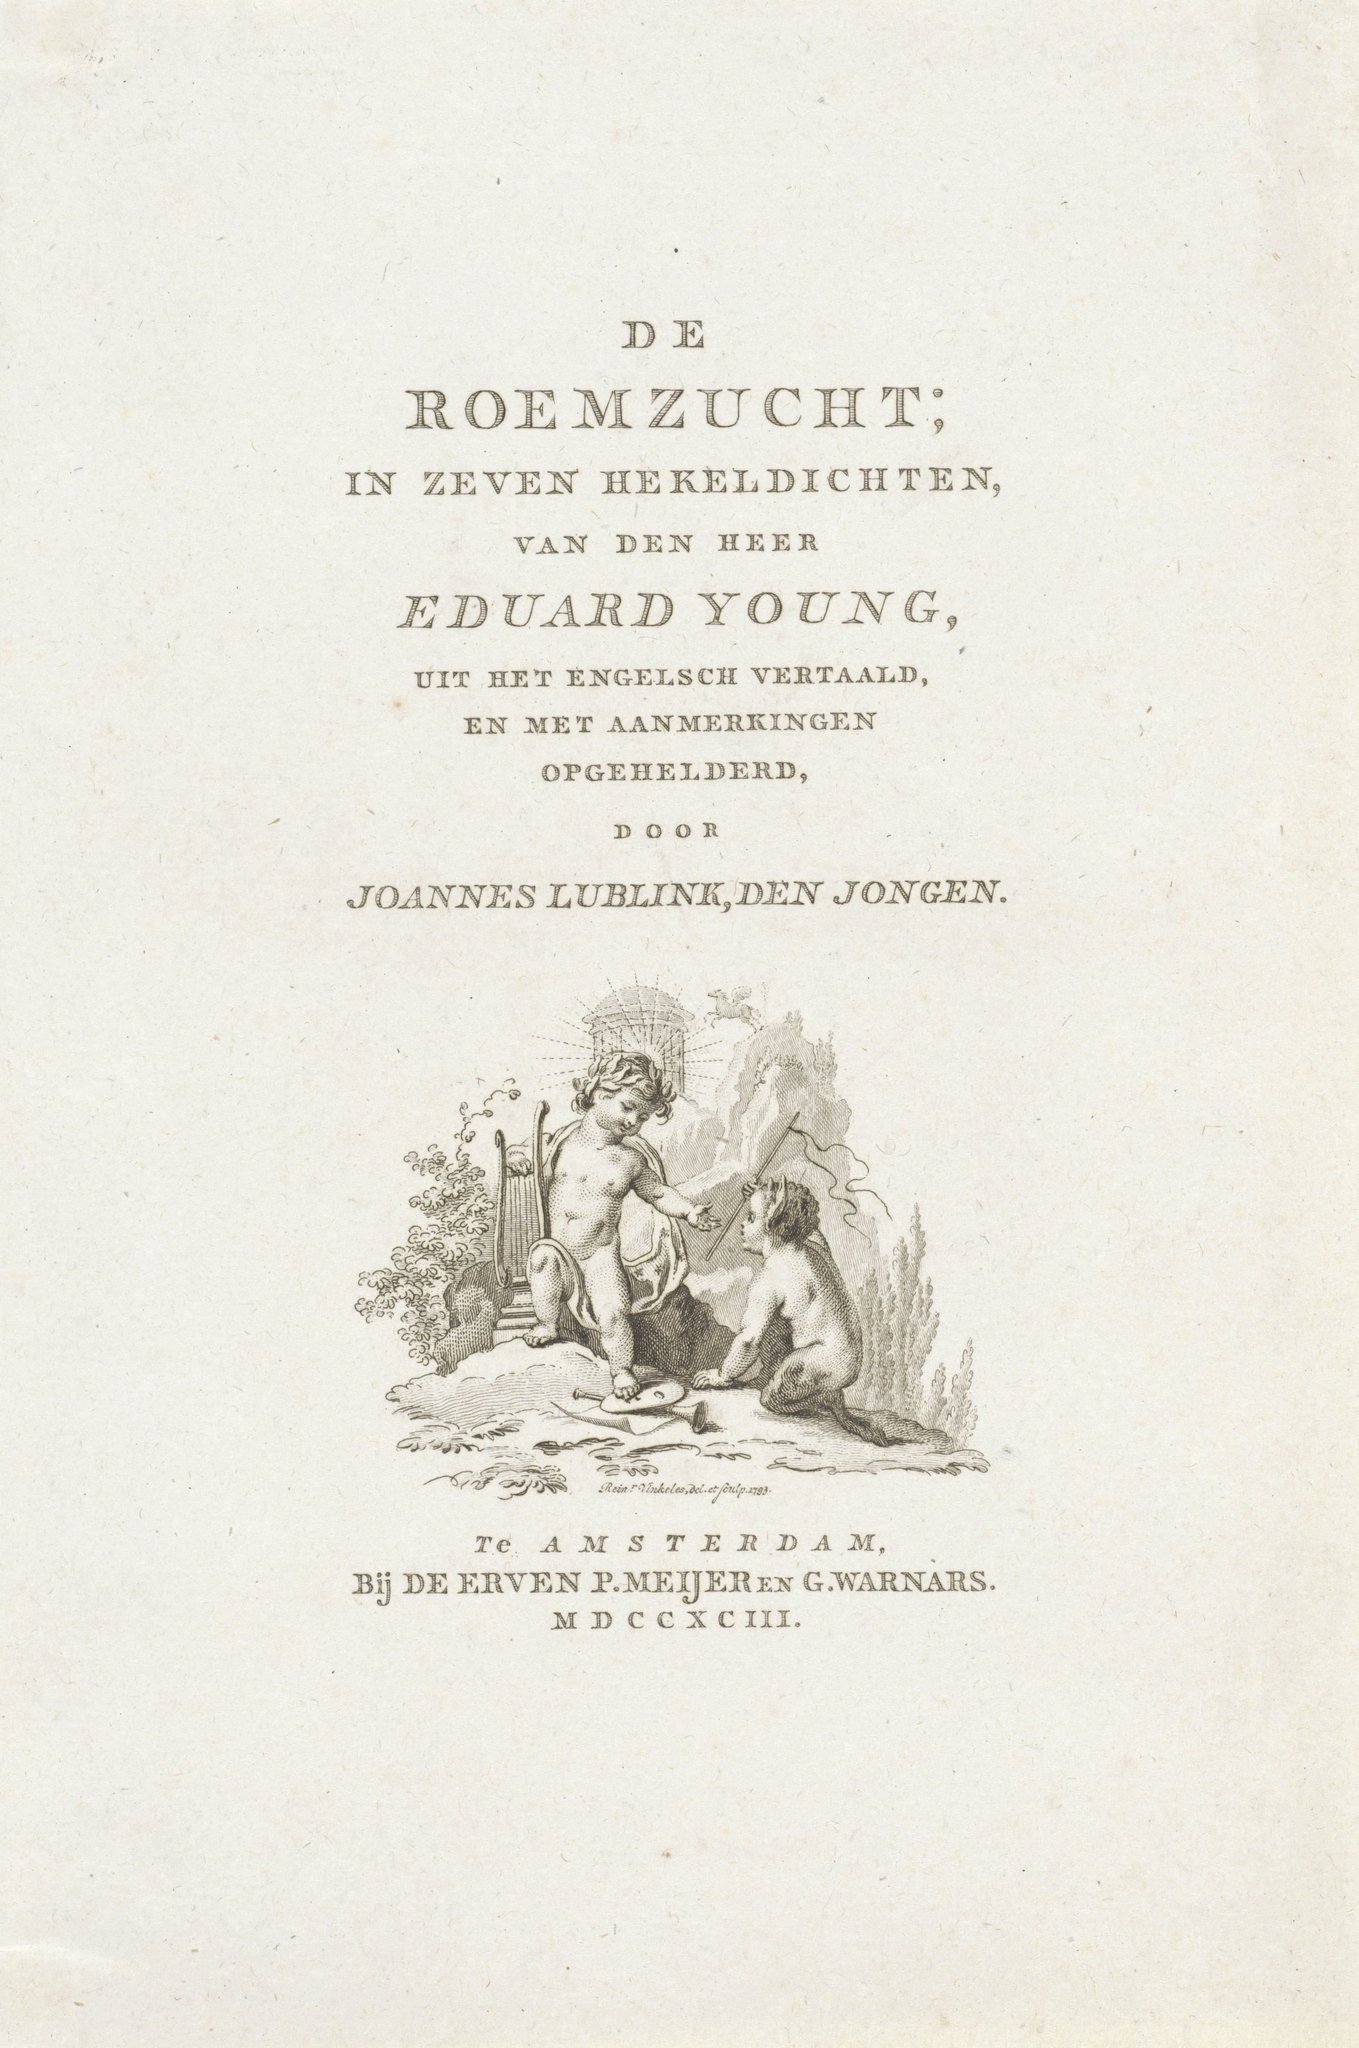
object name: titelblad, titelpagina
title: Titelpagina voor: Eduard Young, 'De roemzucht', 1793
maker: reinier vinkeles (i)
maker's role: draughtsman, print maker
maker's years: 1741-1816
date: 1793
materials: paper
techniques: etching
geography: amsterdam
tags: devil(s) and demons, harp, cupids: 'amores', 'amoretti', 'putti'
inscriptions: collector's mark: Lugt 240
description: Titelpagina voor: Young, Eduard. De roemzucht; in zeven hekeldichten. Amsterdam: Pieter Meyer (erven) & Gerrit Warnars, 1793.